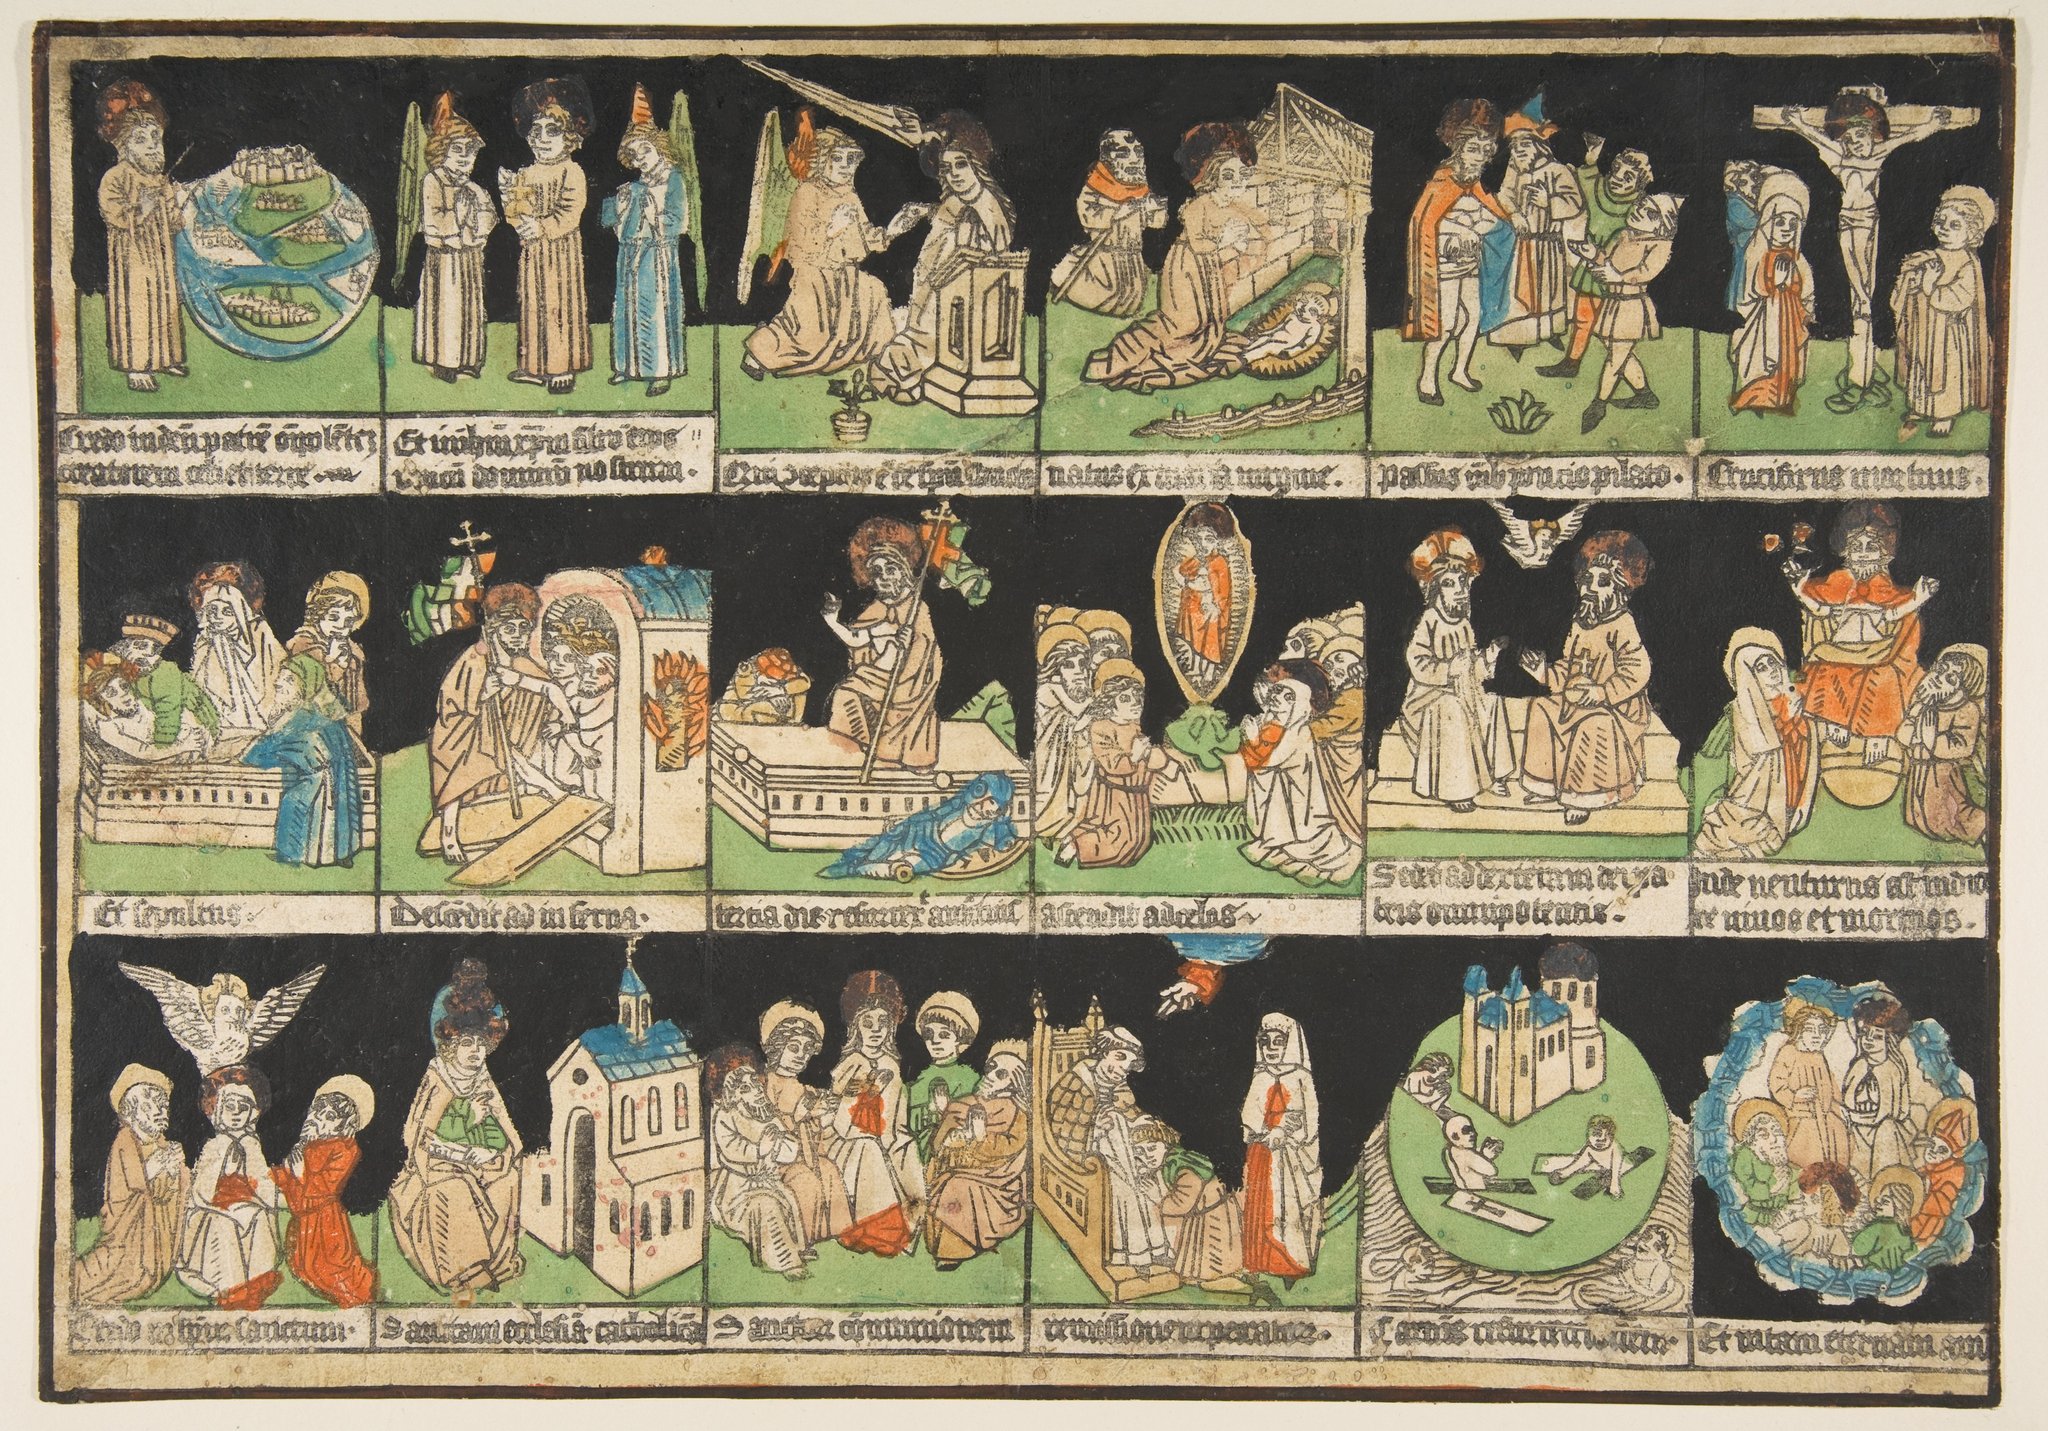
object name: print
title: The Creed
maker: anonymous, german, 15th century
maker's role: artist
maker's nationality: german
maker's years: 1400-1500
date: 1450-1470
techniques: hand coloring, woodcut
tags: human figures,crucifixion